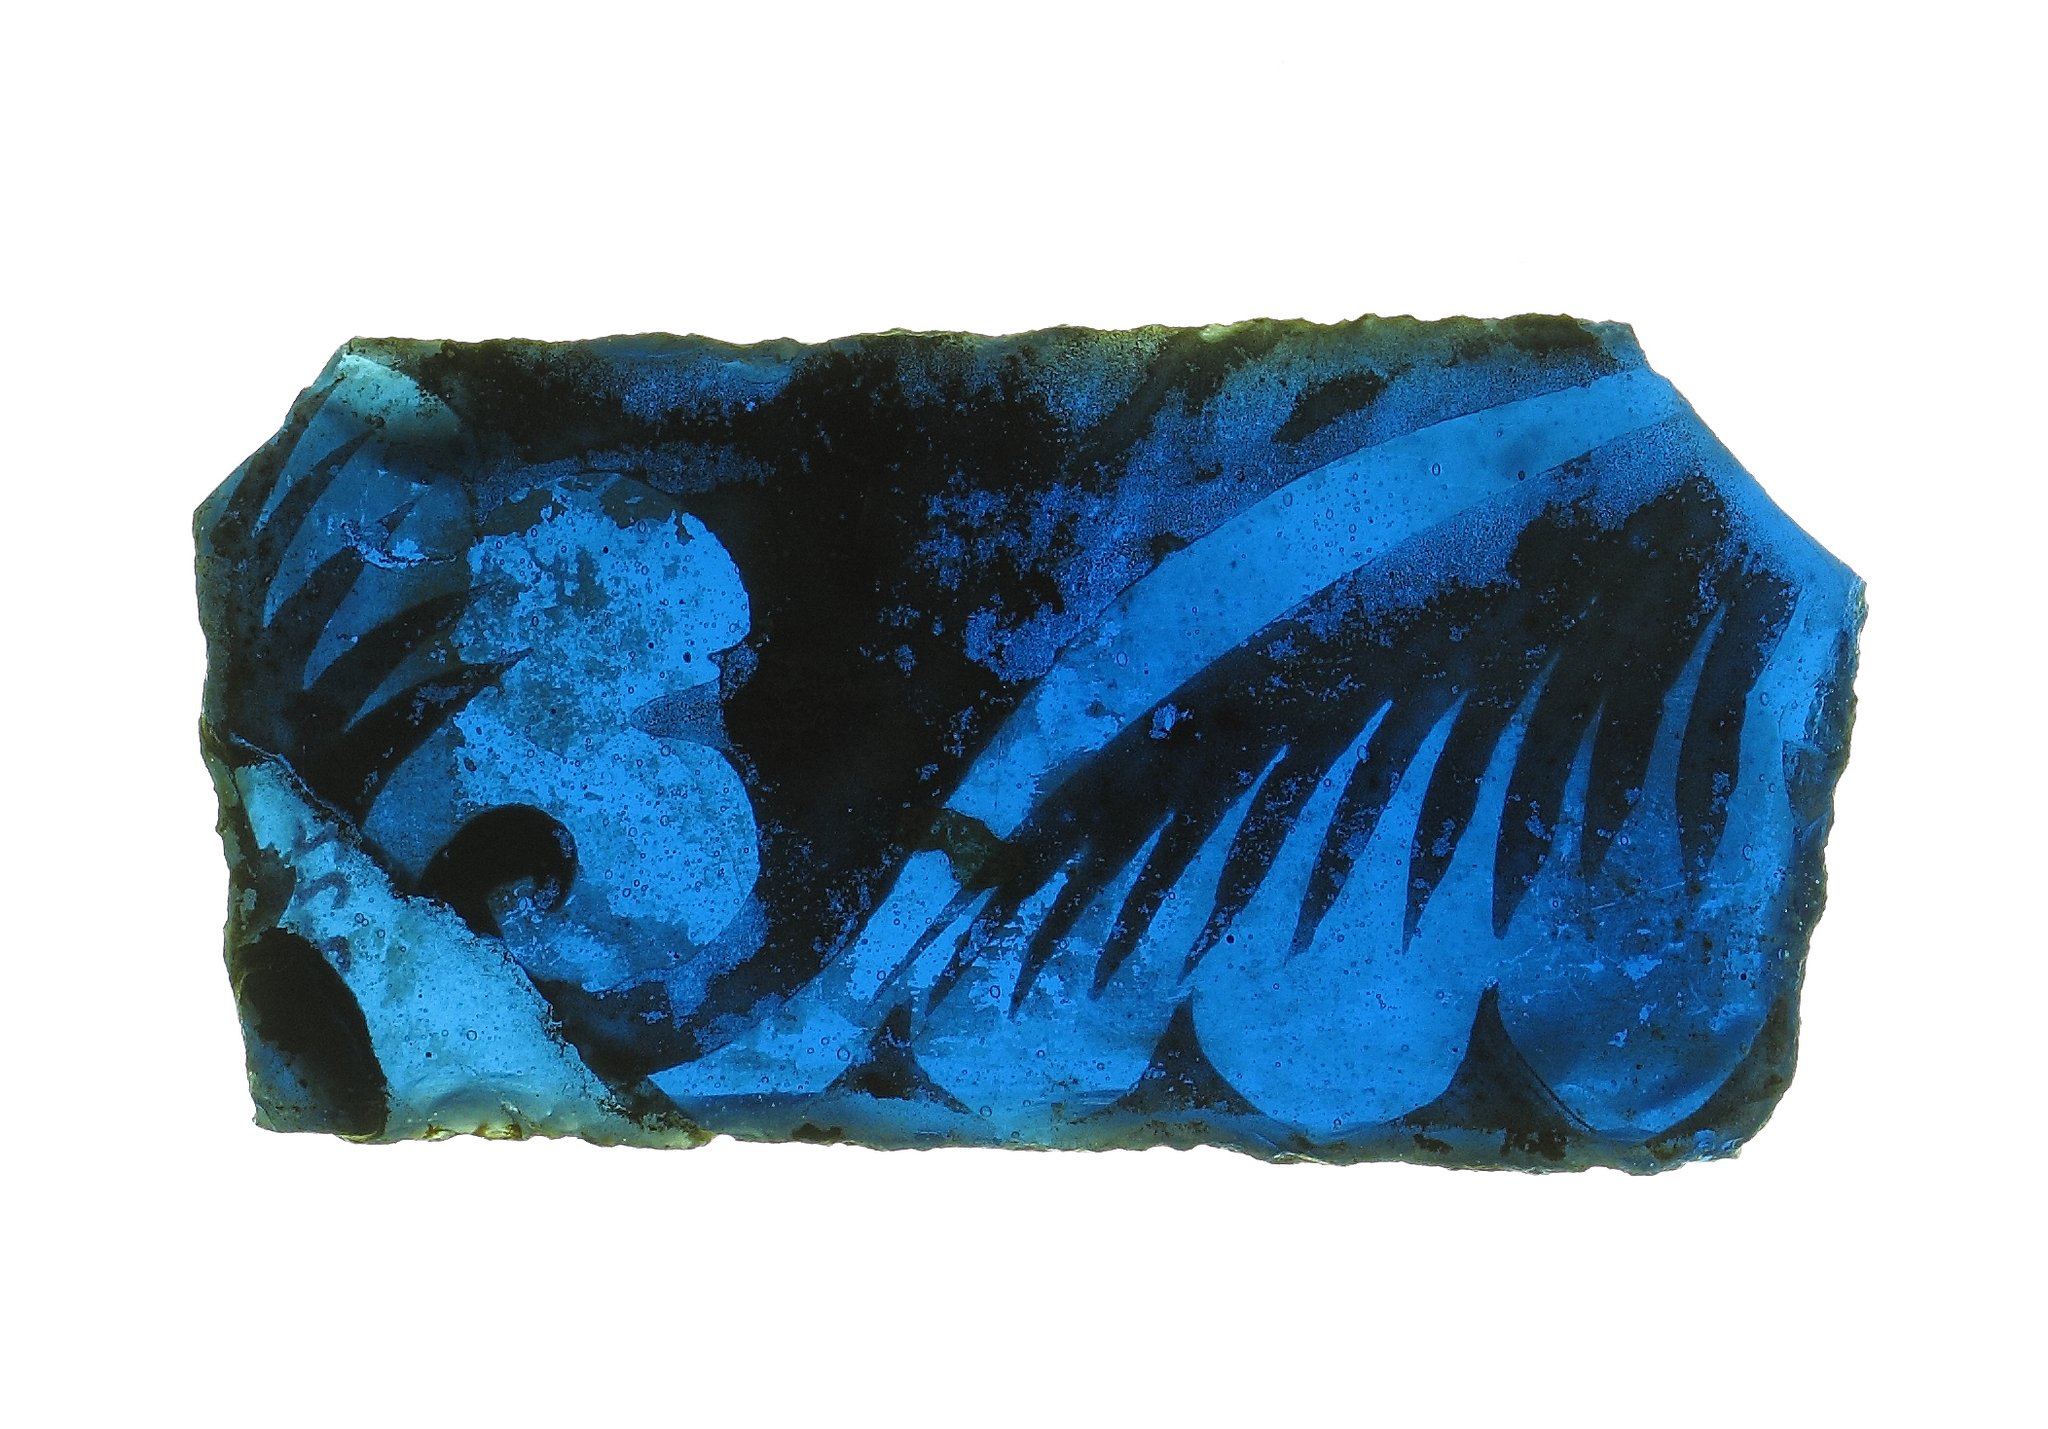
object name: fragment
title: Glass Fragment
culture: french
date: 1101-1200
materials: glass, metal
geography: france